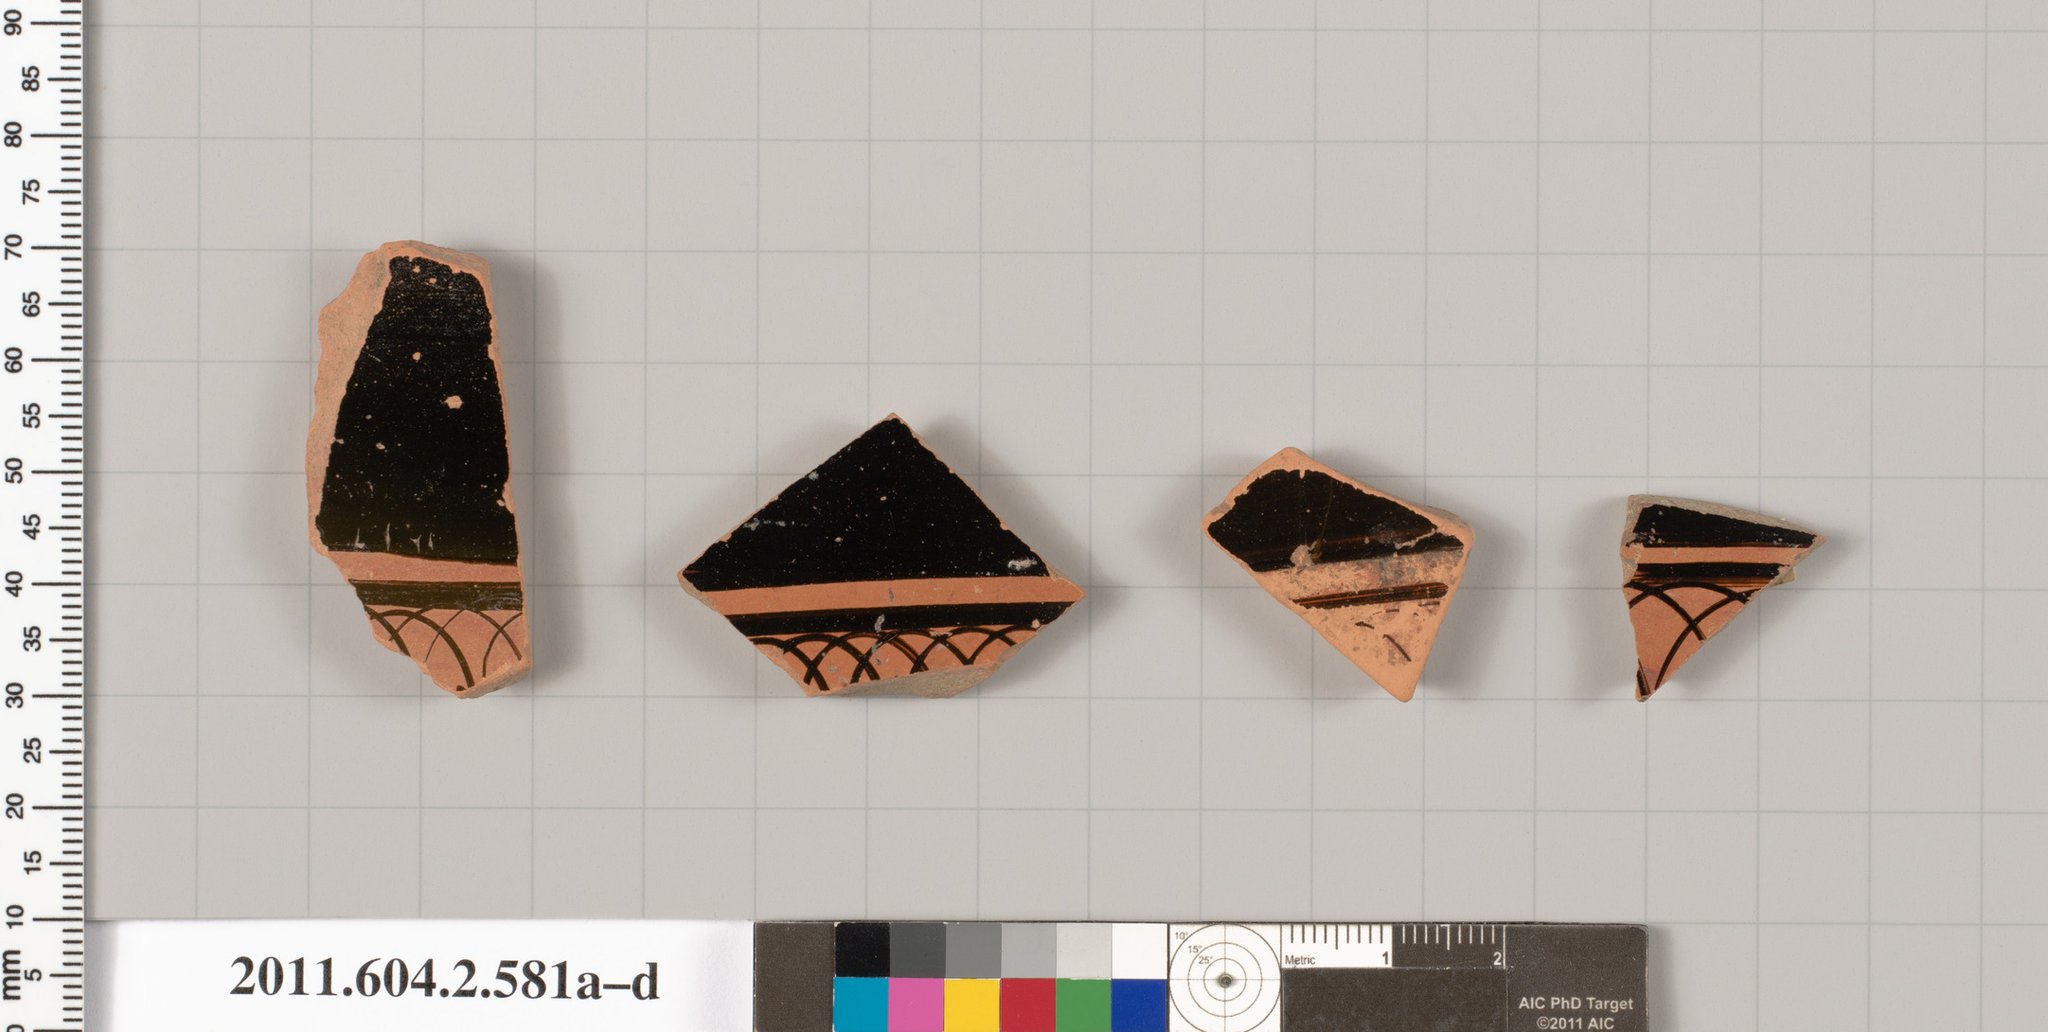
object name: column krater fragment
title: Terracotta fragments of column-kraters (bowls for mixing wine and water)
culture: greek, attic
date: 470-440 BCE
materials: terracotta